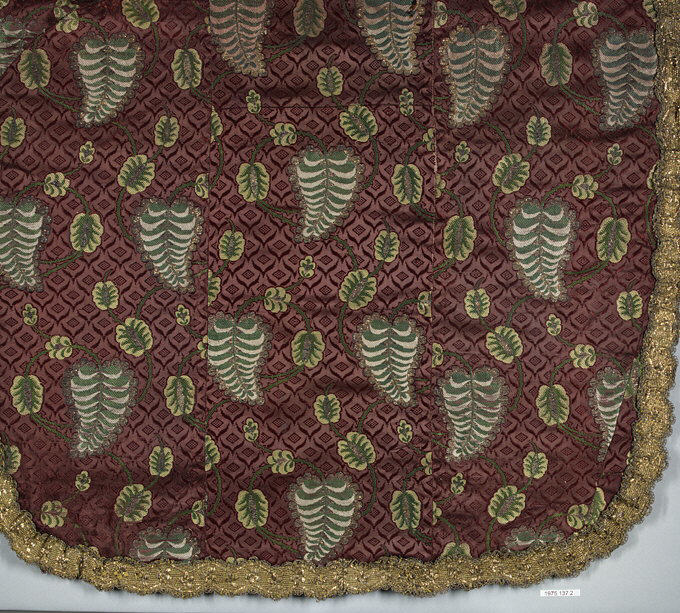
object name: length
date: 1734-1766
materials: metal thread, silk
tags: leaves